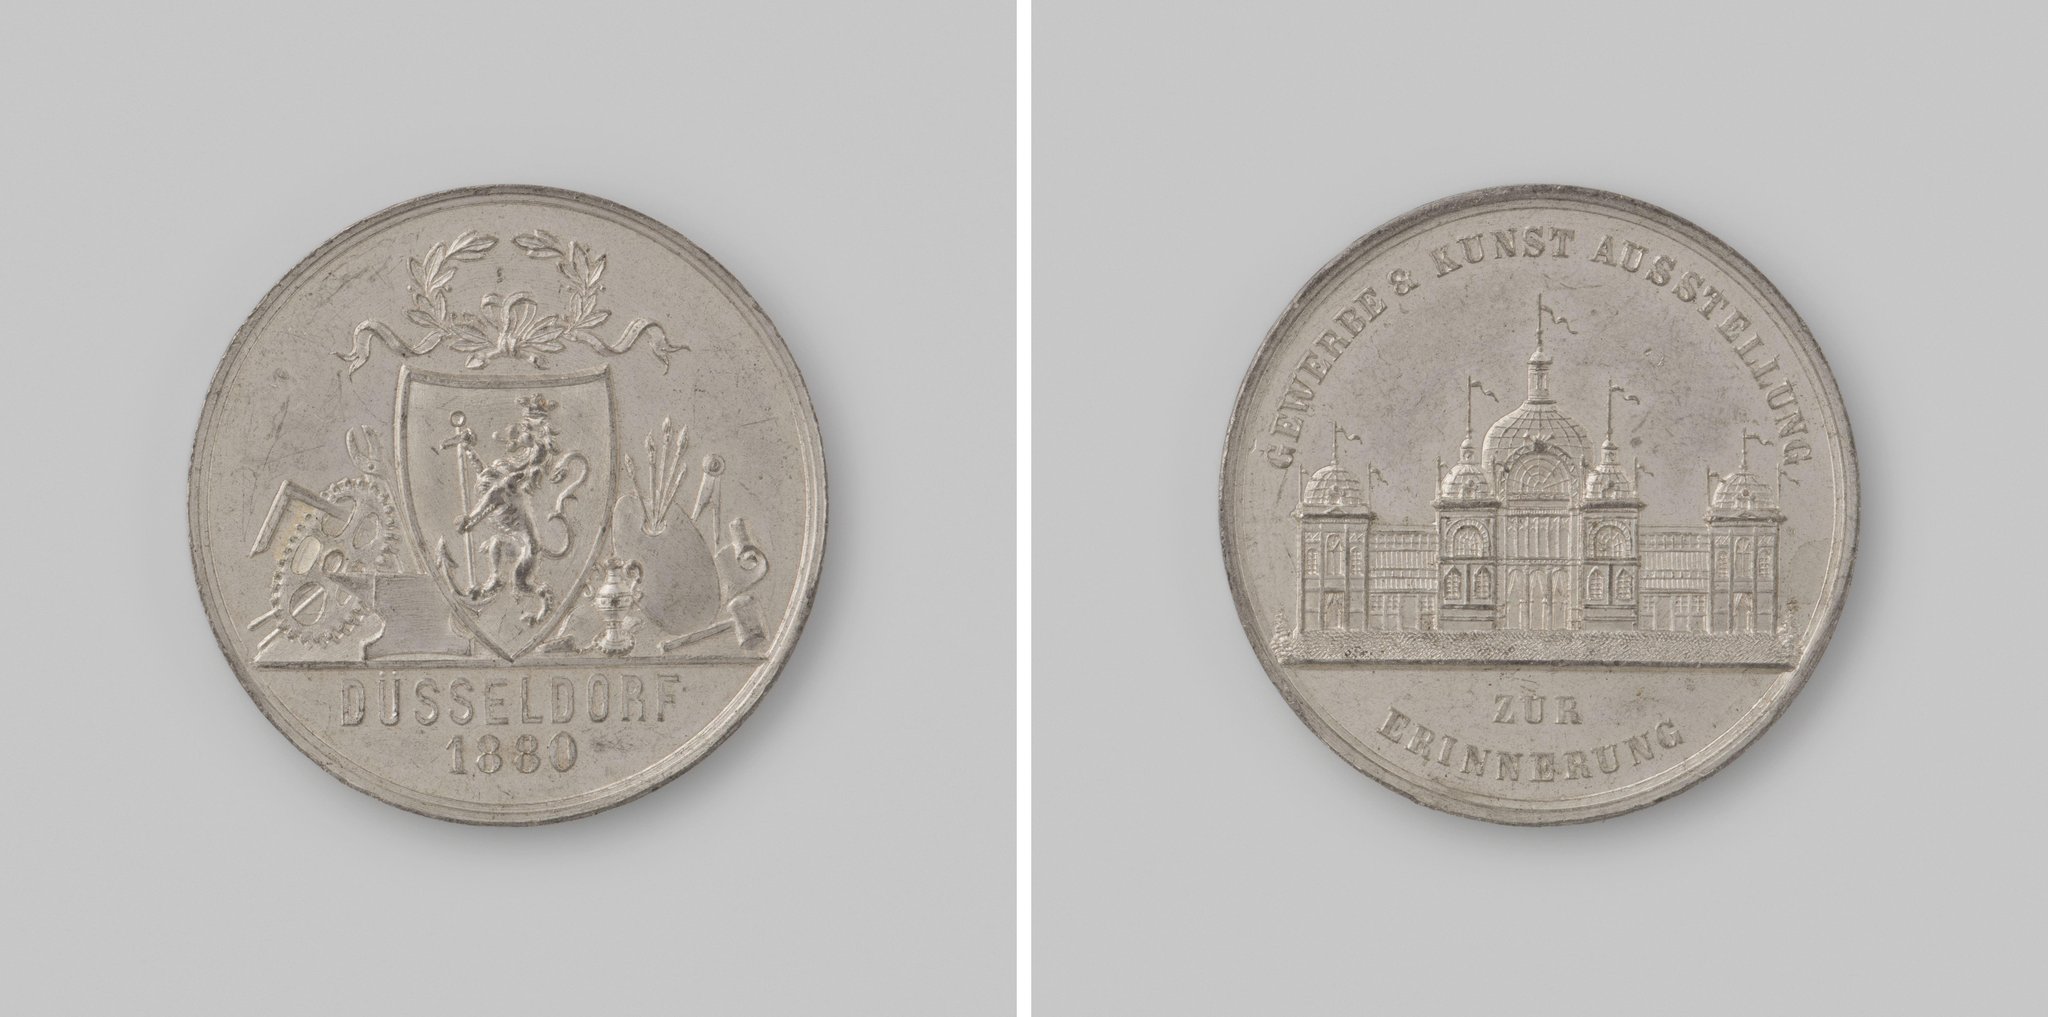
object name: history medal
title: Kunstnijverheidstentoonstelling te Düsseldorf 1880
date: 1880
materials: tin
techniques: striking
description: Tinnen penning, op de voorzijde het gelauwerde wapenschild van Düsseldorf te midden van symbolen van nijverheid en kunst, met afsnedetekst, op de keerzijde het tentoonstellingsgebouw met omschrift.